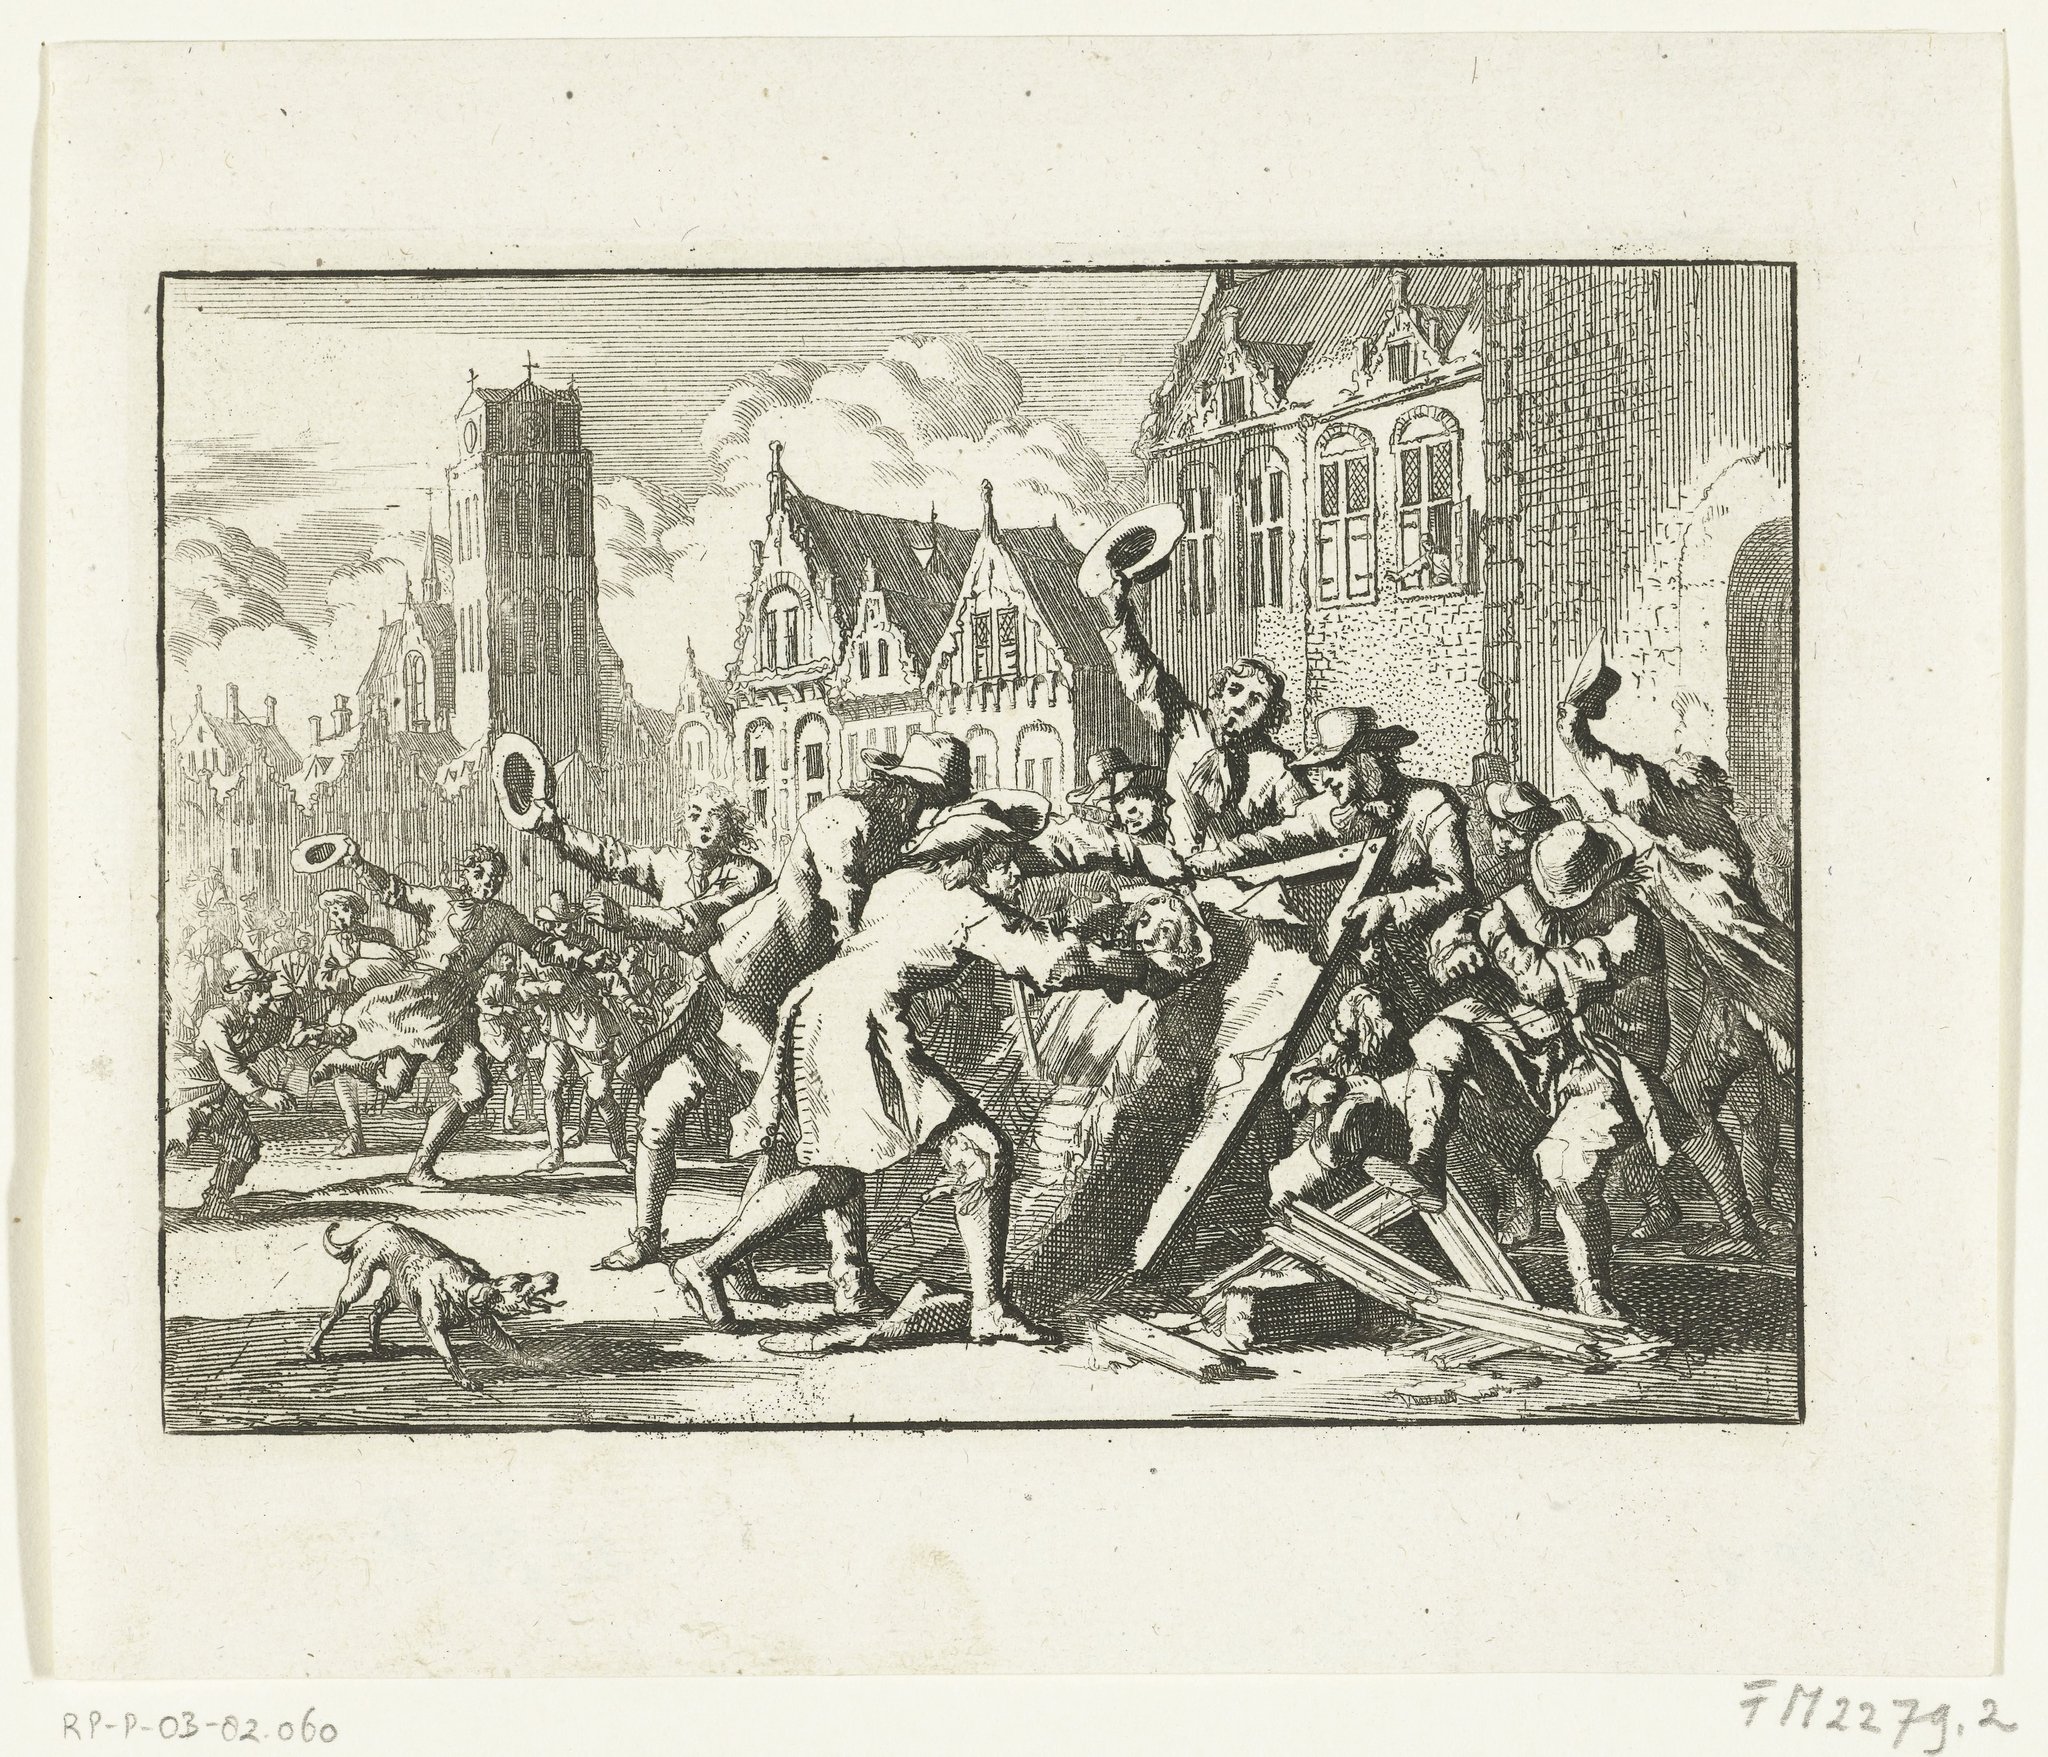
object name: history print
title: Vernietiging door het volk te Dordrecht van het schilderij ter ere van Cornelis de Witt, 1672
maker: jan luyken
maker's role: draughtsman, print maker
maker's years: 1649-1712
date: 1700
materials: paper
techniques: etching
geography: amsterdam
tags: cornelis de witt, art (+ work of art damaged by iconoclasm), street-fights, riots, raid on the medway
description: Prent ook gebruik in: Vries, Simon de. Vervolgh op J. L. Gottfrieds Historische Kronyk / Omstandigh vervolgh op Joh. Lodew. Gottfrieds Historische Kronyck,: of algemeene historische Gedenk-Boeken […] Keyser Rudolph de II. in 't jaer 1576 […]Vreede te Ryswijck Anno 1697 […]. 2 delen. Leiden: Pieter van der Aa, 1698-1700, dl. 2 (1700) p. 1295-1296.